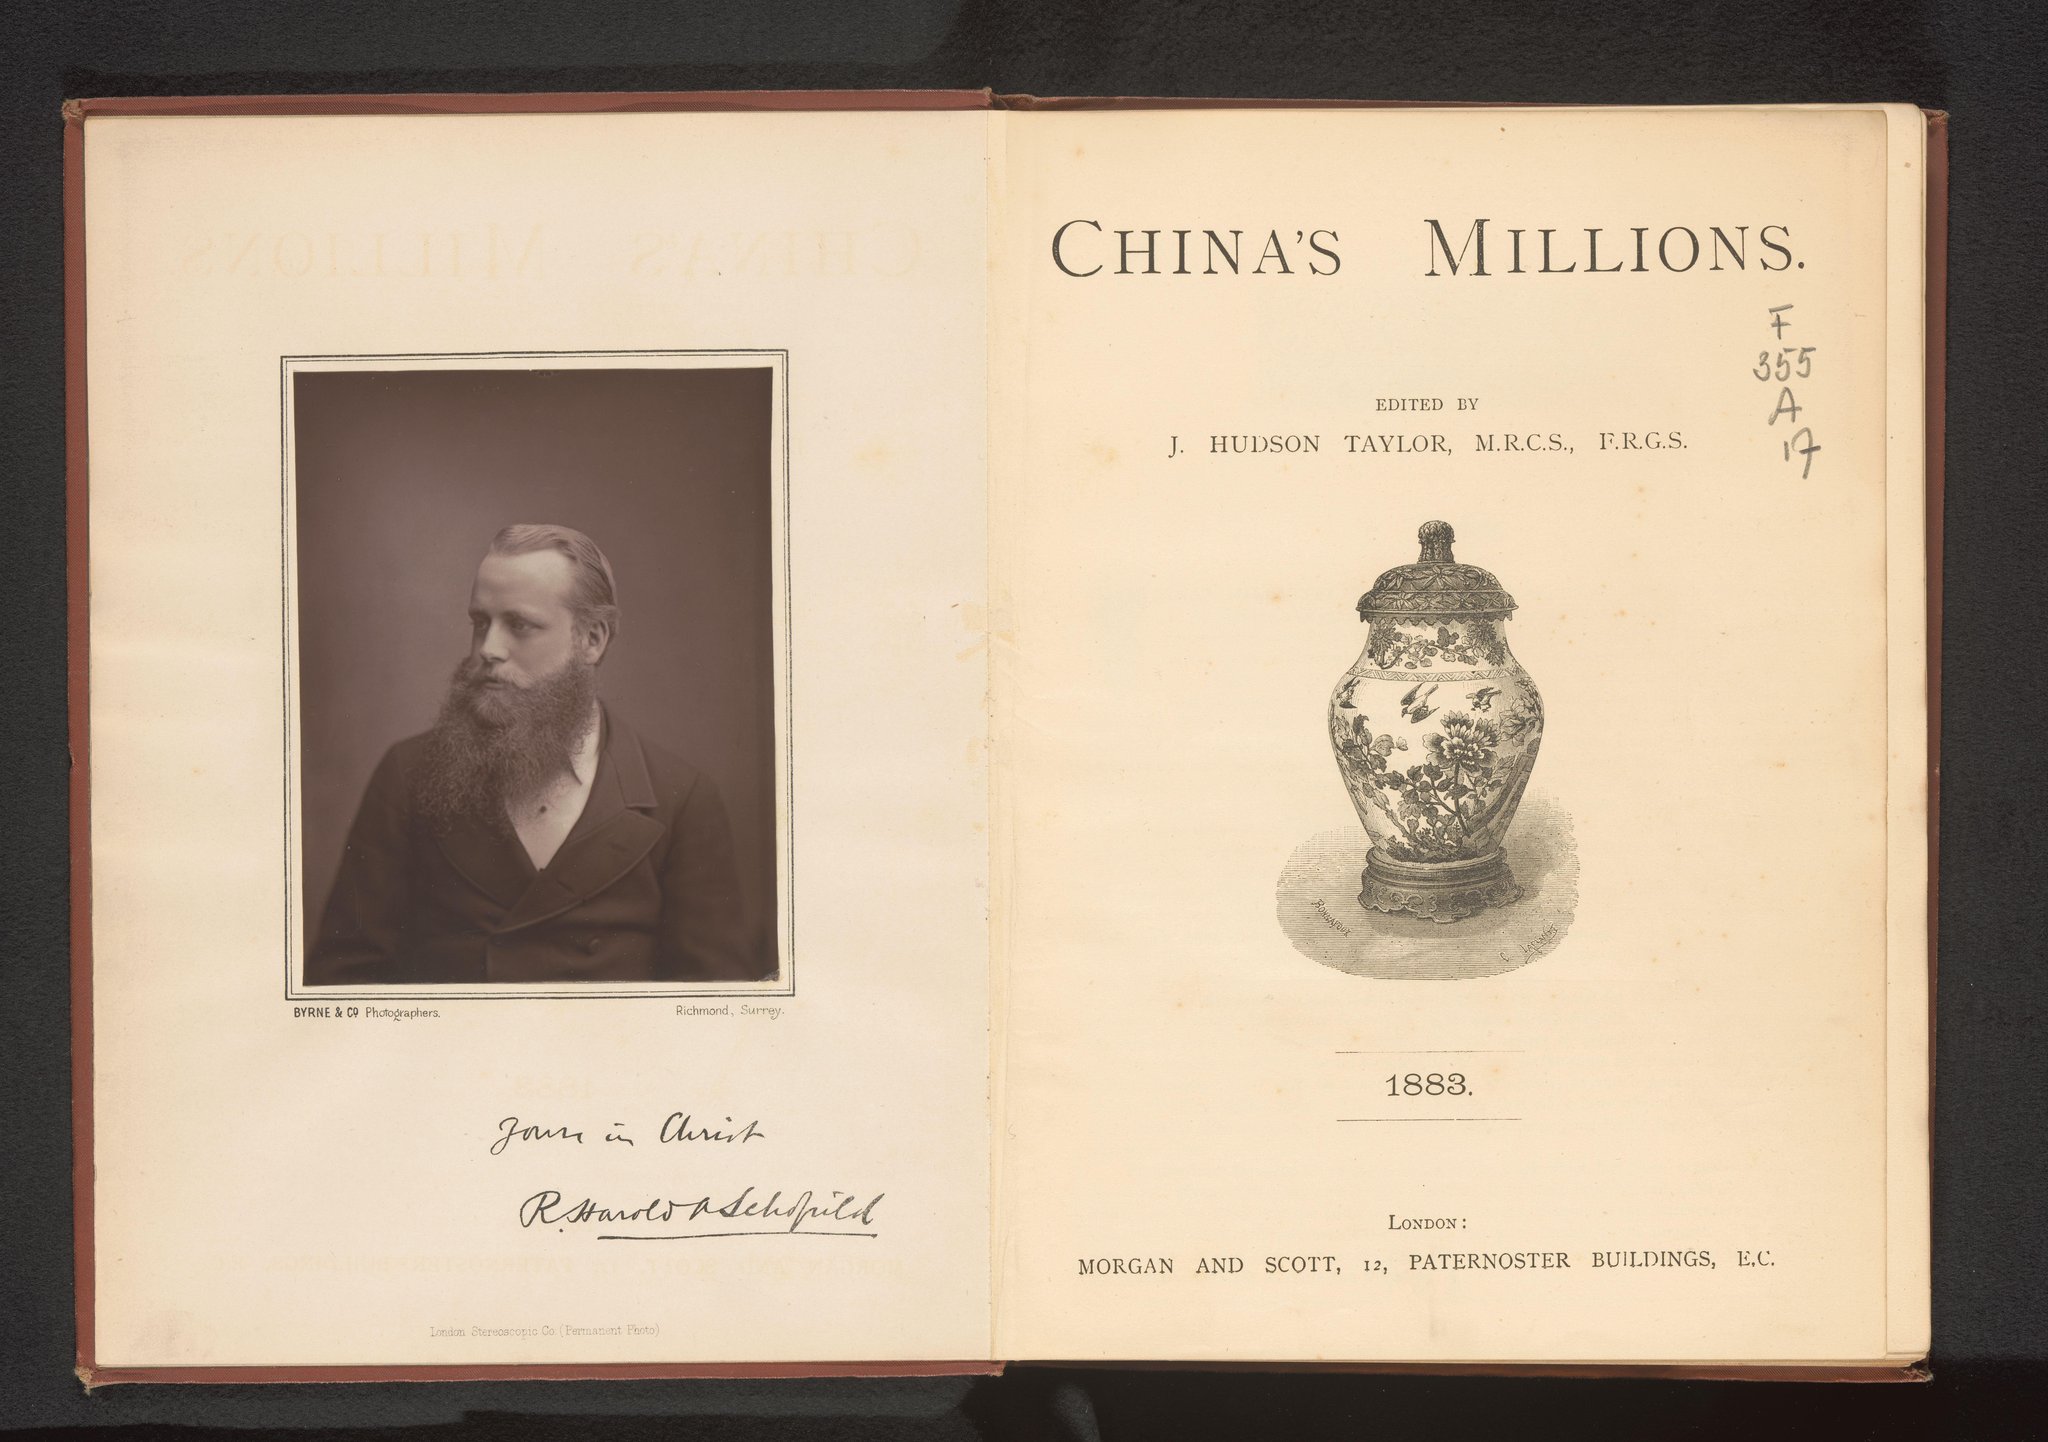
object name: photomechanical print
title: Portret van Robert Harold Ainsworth Schofield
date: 1873-1883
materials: paper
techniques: woodburytype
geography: richmond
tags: missionary, historical persons, spreading the gospel; missionary work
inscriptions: inscription: ‘Yours in Christ R. Harold Schofield’